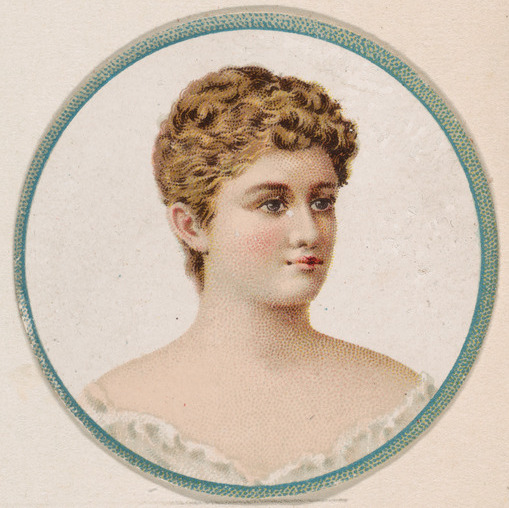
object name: print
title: Portrait of woman, from the Novelties series (N228, Type 2) issued by Kinney Bros.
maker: kinney brothers tobacco company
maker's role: publisher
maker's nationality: american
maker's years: 1869-2011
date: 1889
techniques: color lithograph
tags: portraits,women